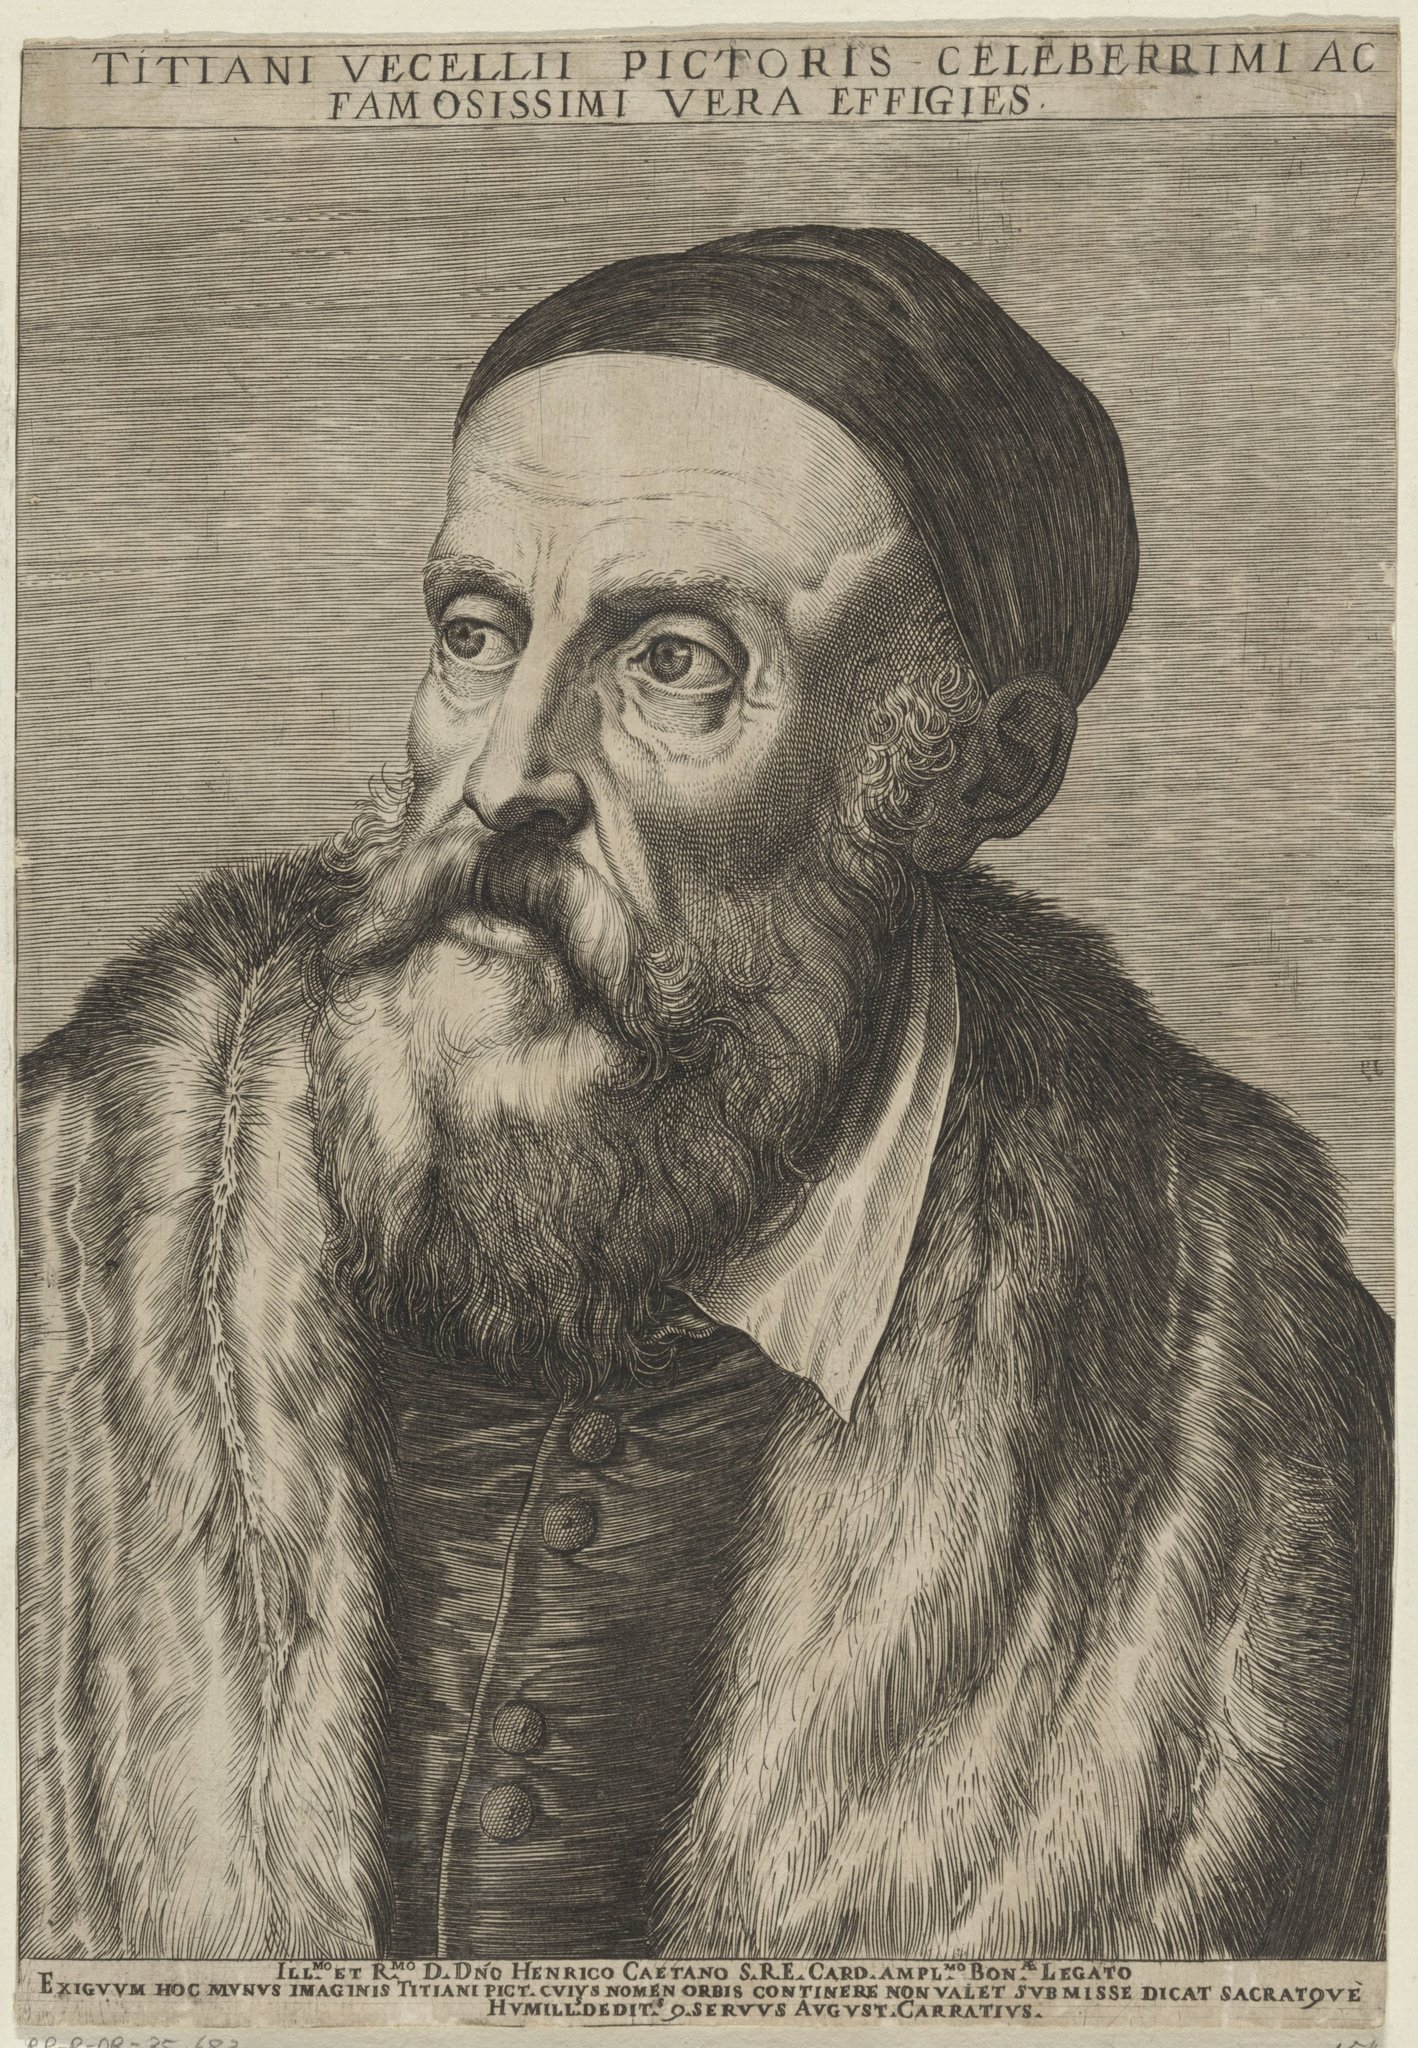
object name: print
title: Portret van schilder Titiaan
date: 1587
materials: paper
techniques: engraving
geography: italy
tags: venice, painter, draughtsman, titiaan, historical persons, portrait, self-portrait of artist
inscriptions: collector's mark: Lugt 240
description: Naar geschilderd zelfportret van Titiaan in de Staatliche Museen Preussischer Kulturbesitz, Gemäldegalerie te Berlijn.